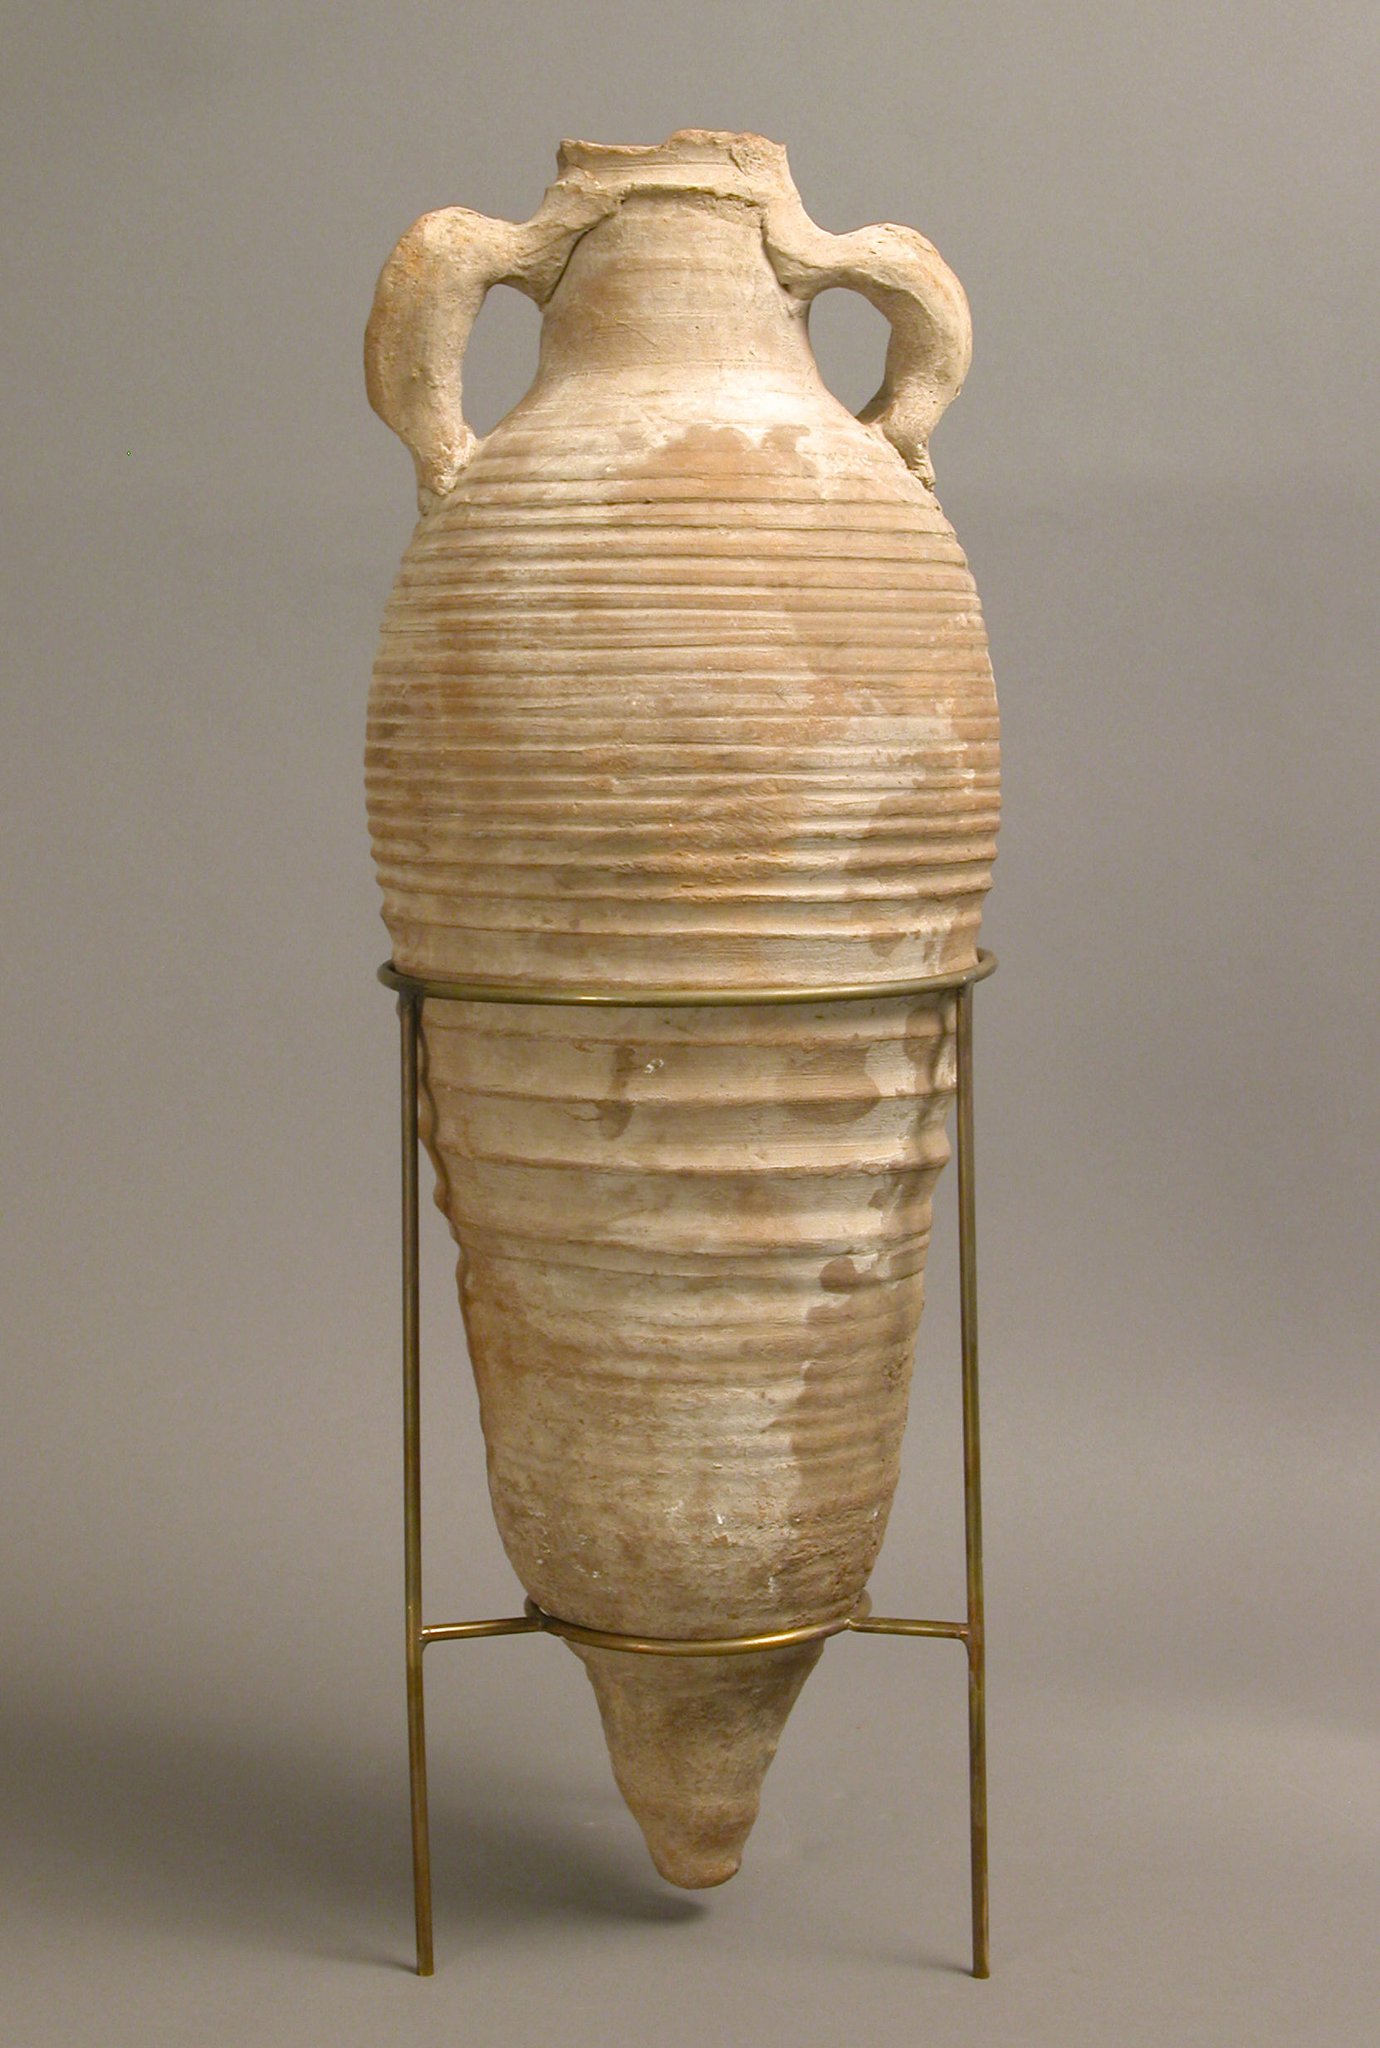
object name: amphora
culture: coptic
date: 367-700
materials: earthenware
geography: egypt